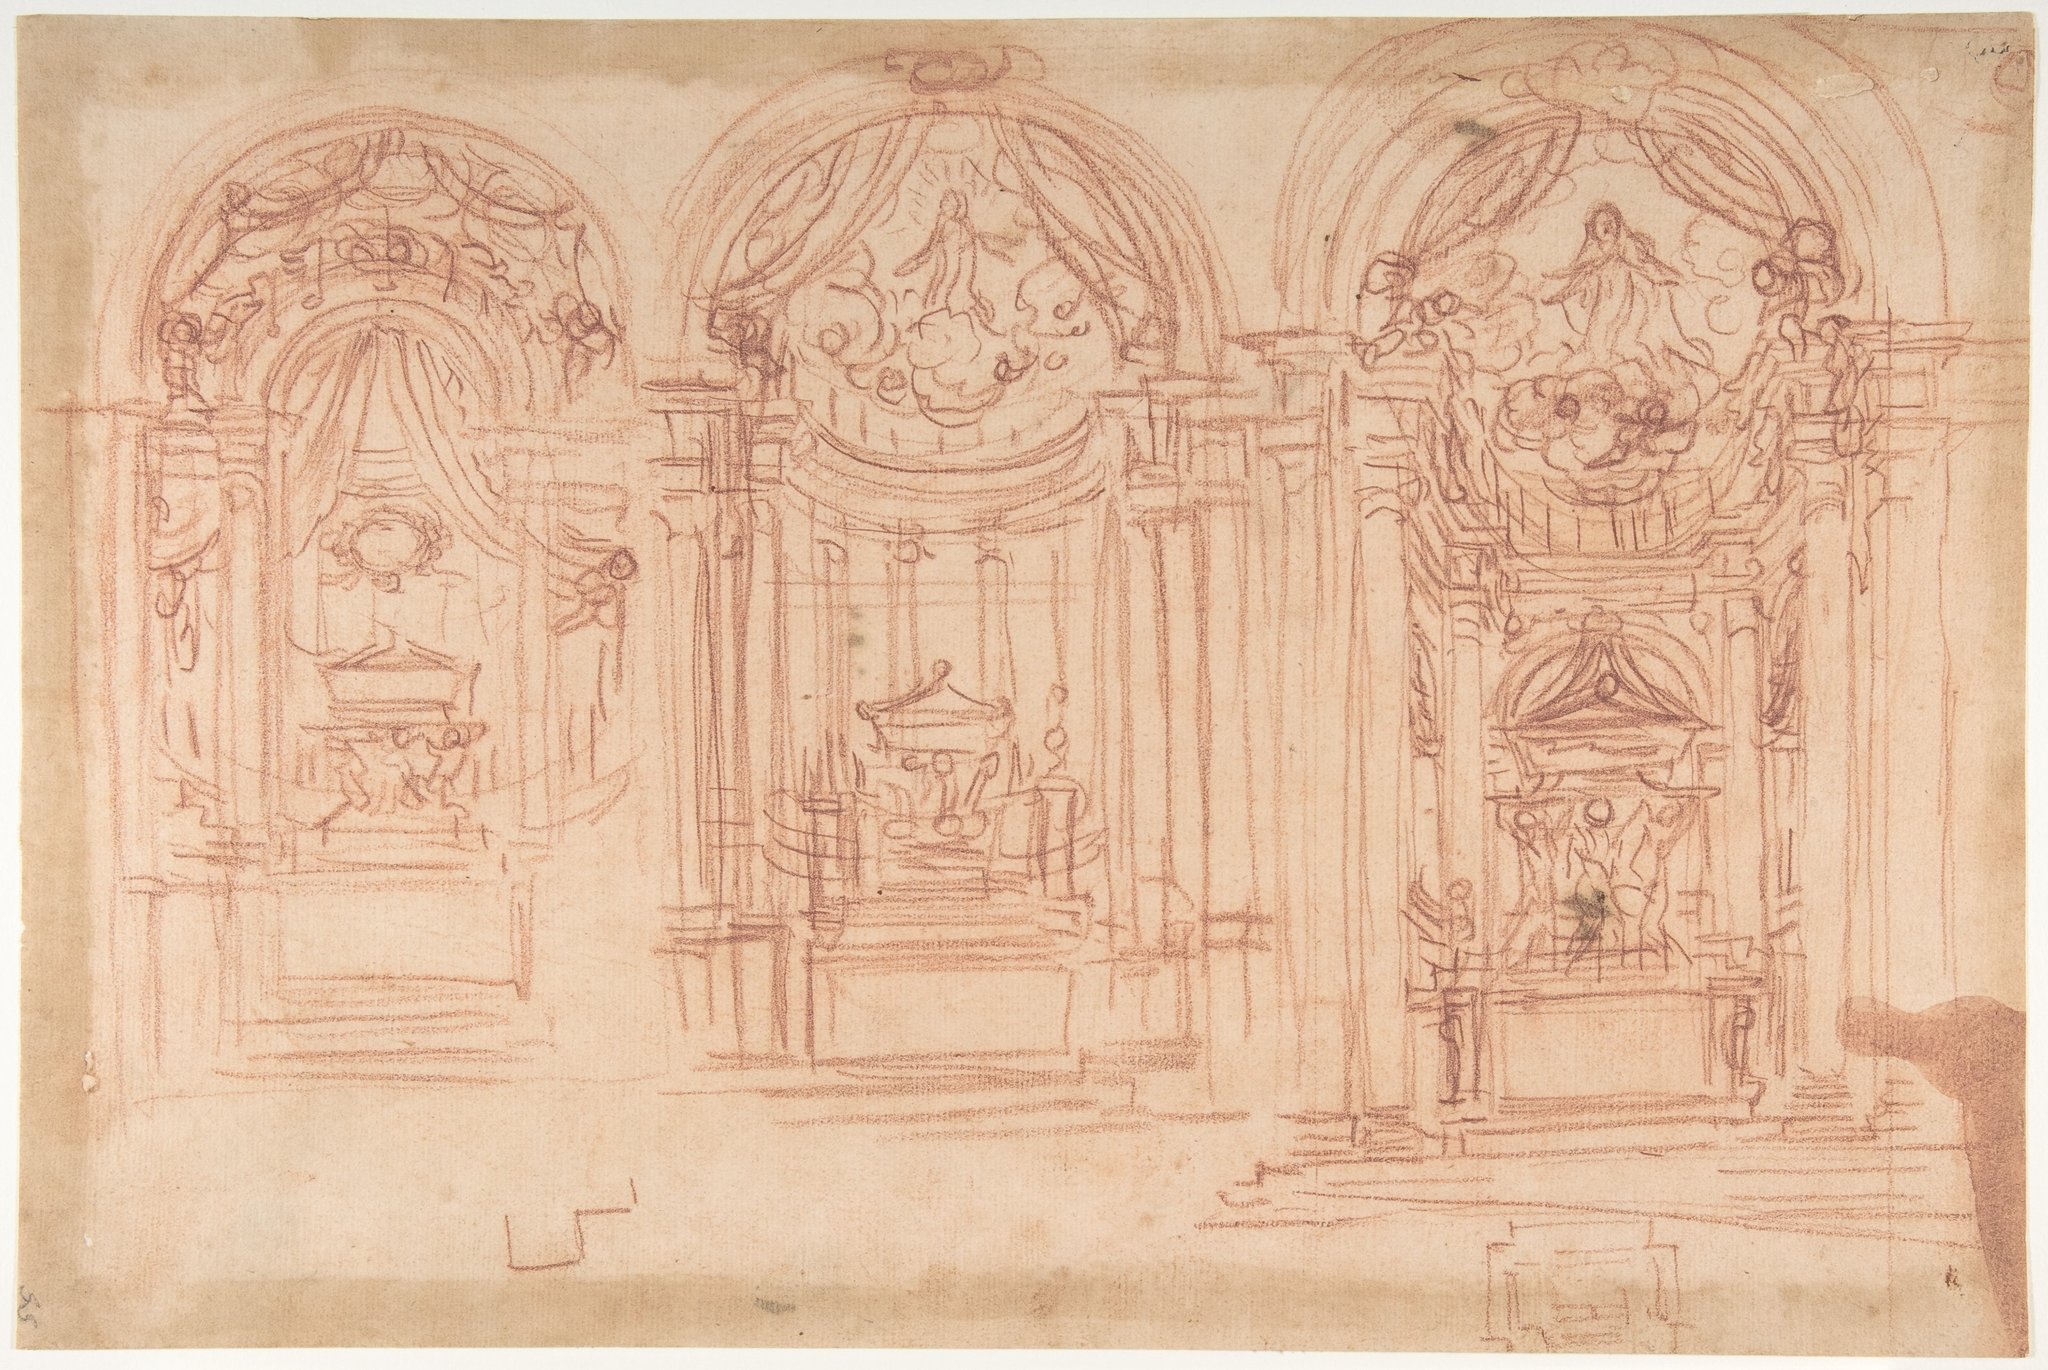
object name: drawing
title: Design for a Catafalgue Used on the Occasion of the Canonization of Saint Mary Magdalen de' Pazzi, Florence, 1669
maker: baldassarre franceschini (il volterrano)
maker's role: artist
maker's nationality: italian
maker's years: 1611-1690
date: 1669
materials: chalk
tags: architecture